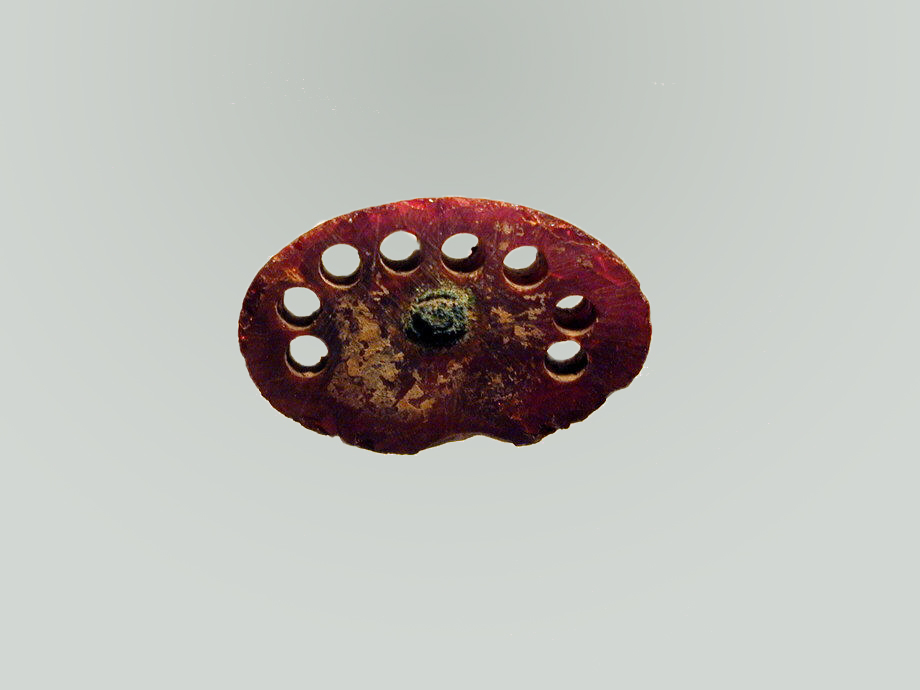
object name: fibula, fragment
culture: etruscan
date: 700-601 BCE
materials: amber